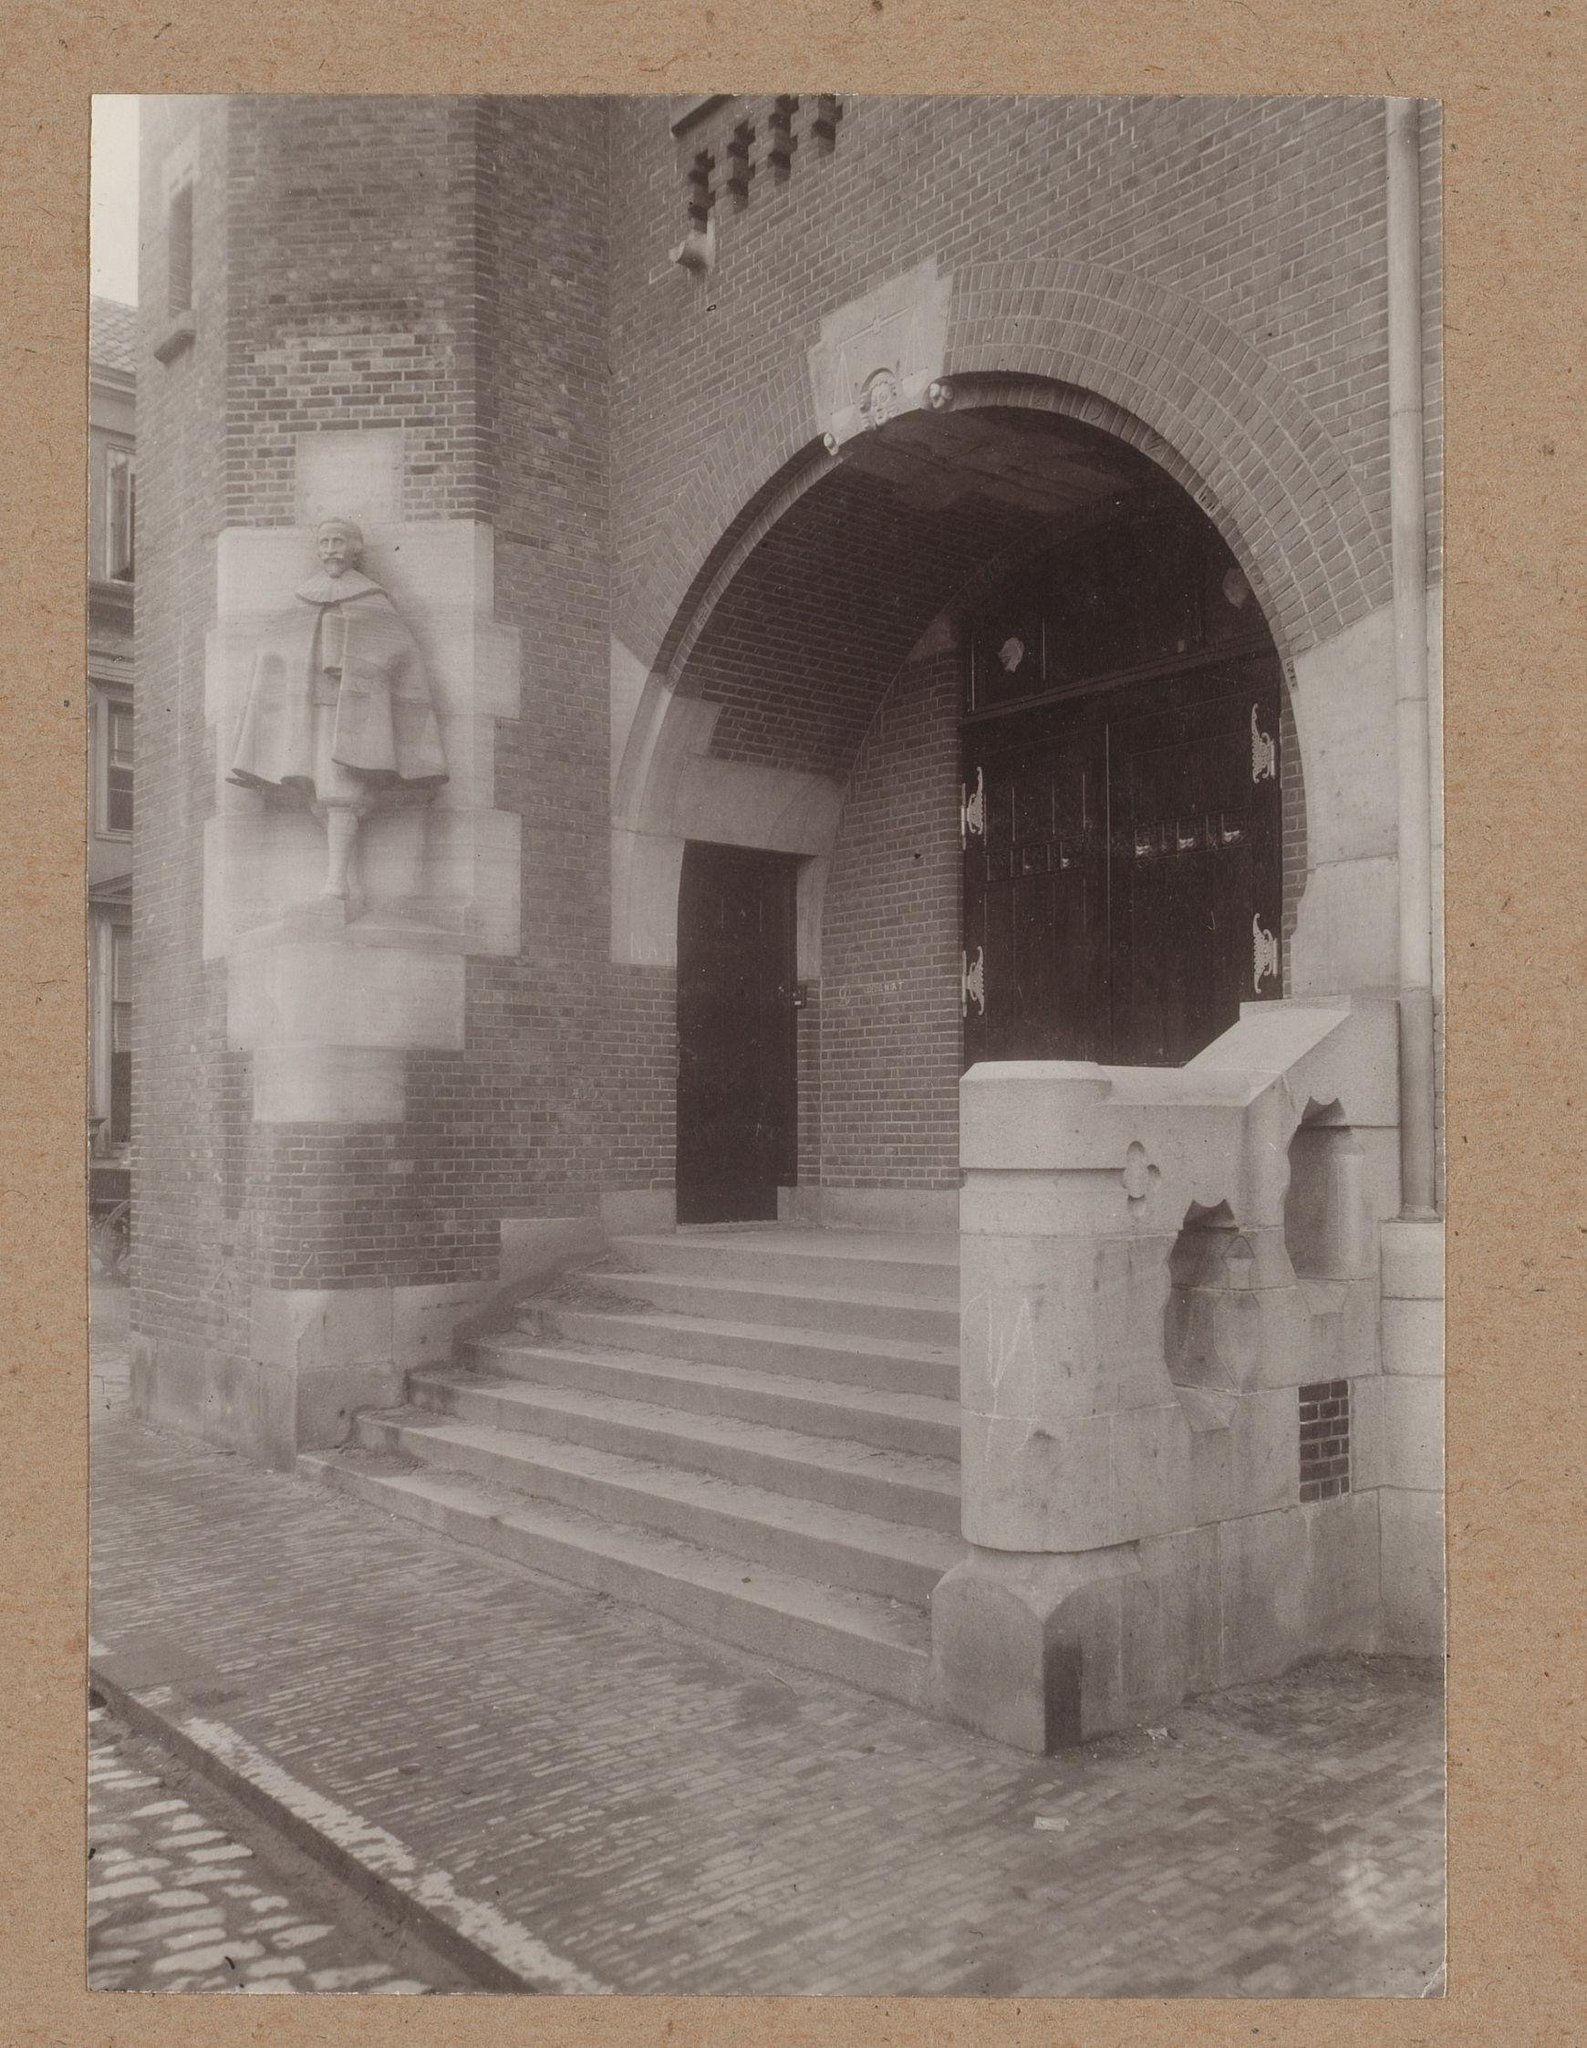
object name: photograph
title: Sculptuur van Hugo de Groot bij de ingang aan het Damrak van de Beurs van Berlage te Amsterdam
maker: Anonymous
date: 1903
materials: paper, cardboard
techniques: gelatin silver print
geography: amsterdam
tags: delft, hugo de groot, piece of sculpture, reproduction of a piece of sculpture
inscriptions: number: ‘4 a b’